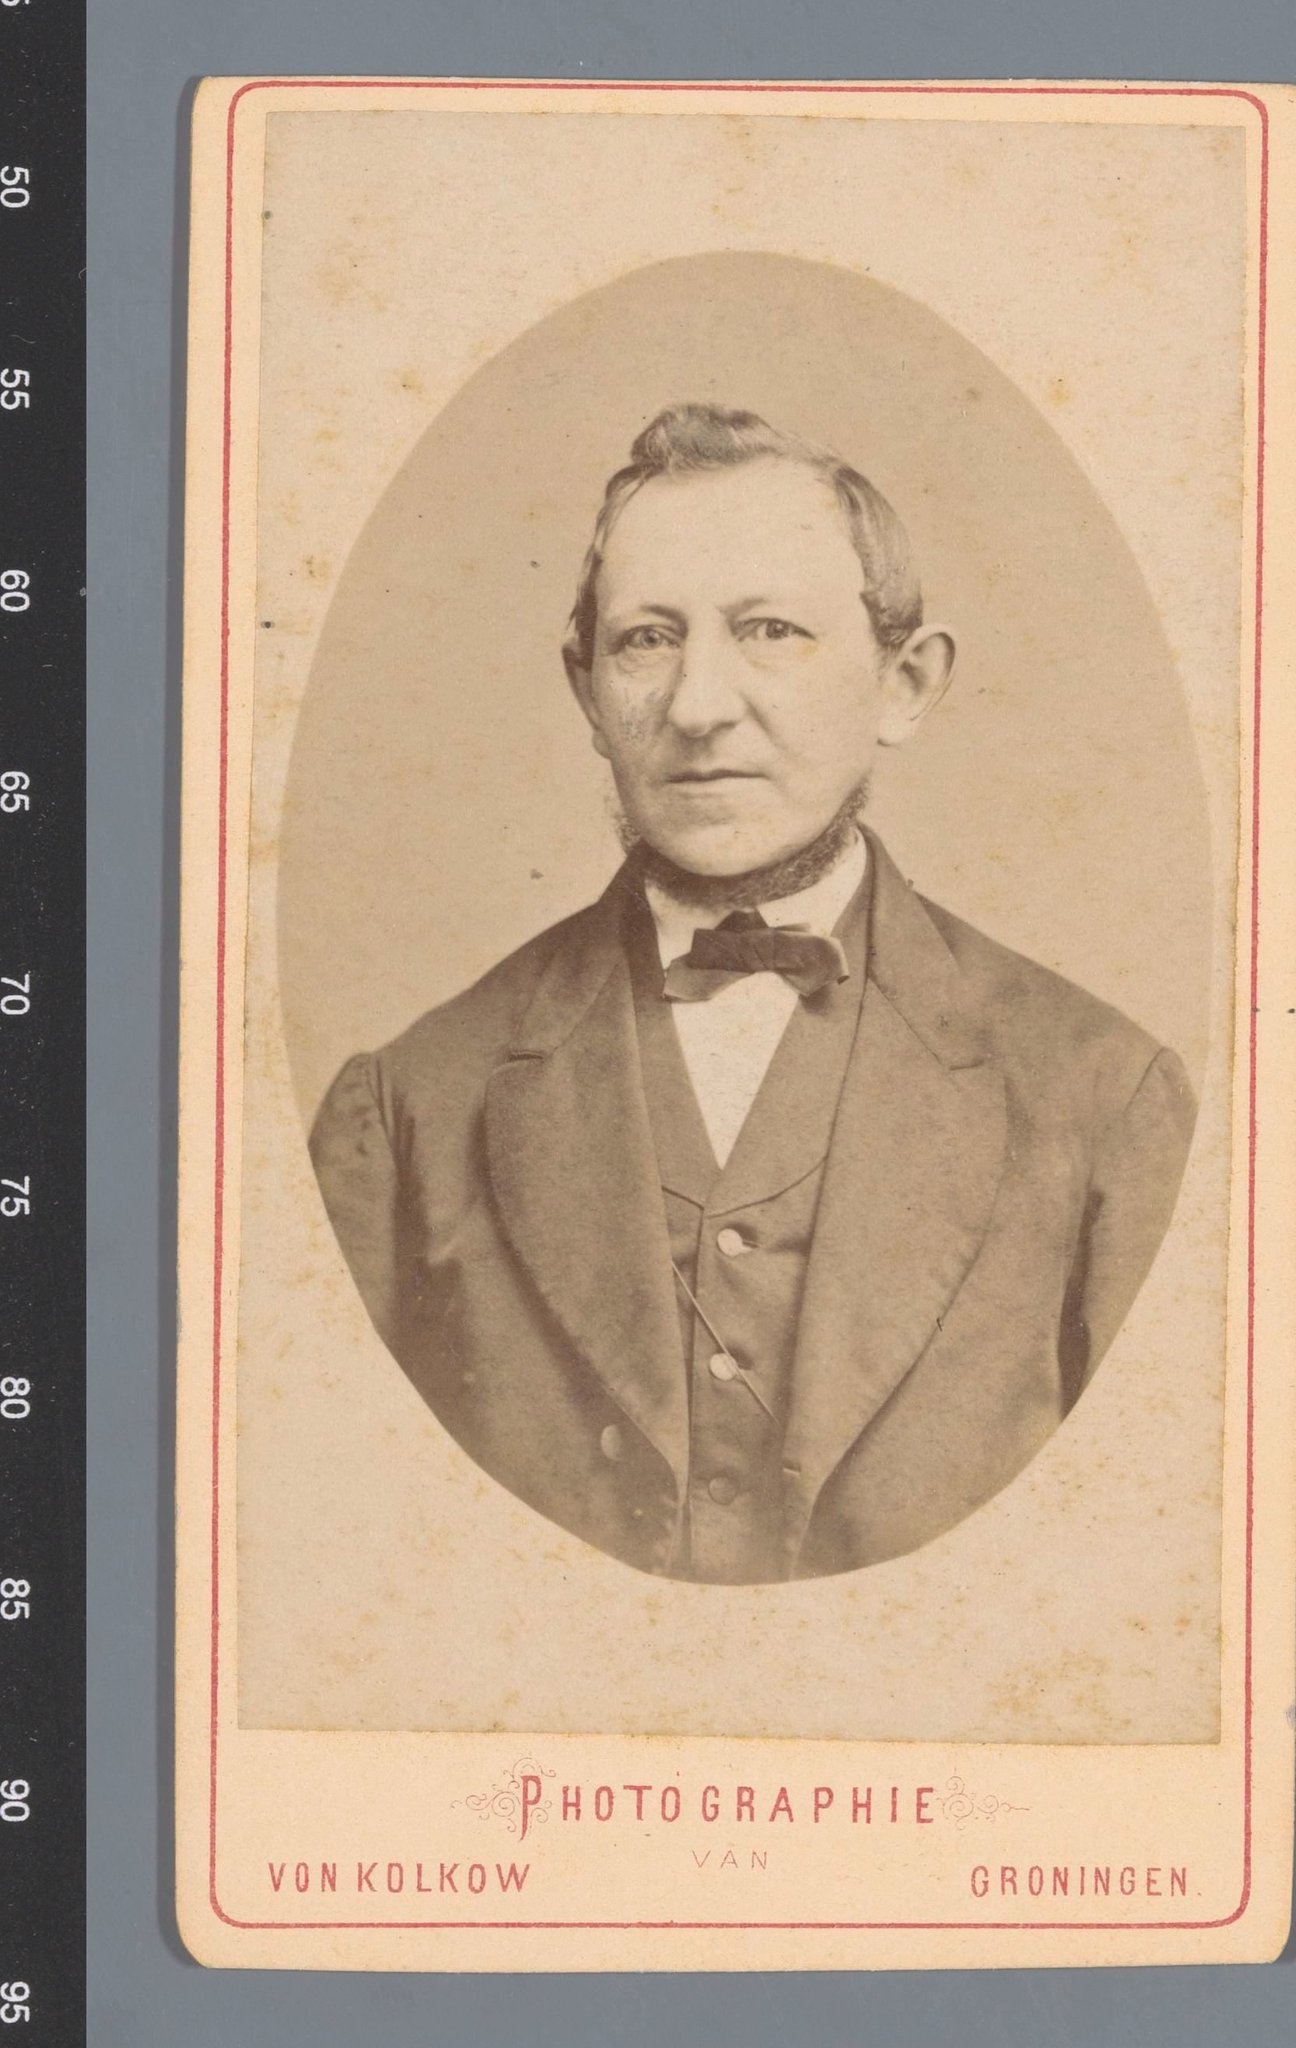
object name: carte de visite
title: Portret van de onderwijzer L. Bouwman Noorddijk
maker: friedrich julius von kolkow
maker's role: fotograaf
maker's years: 1839-1914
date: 1873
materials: cardboard, paper, photographic support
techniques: albumen print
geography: groningen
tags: historical persons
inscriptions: title: ‘Onderwijzer L. Bouwman ... 1873’, signature: ‘Photographie van Von Kolkow Groningen’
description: Carte-de-visite is onderdeel van een groep portretten aangeboden aan A.J. Nijland, verzamelaar van historieprenten